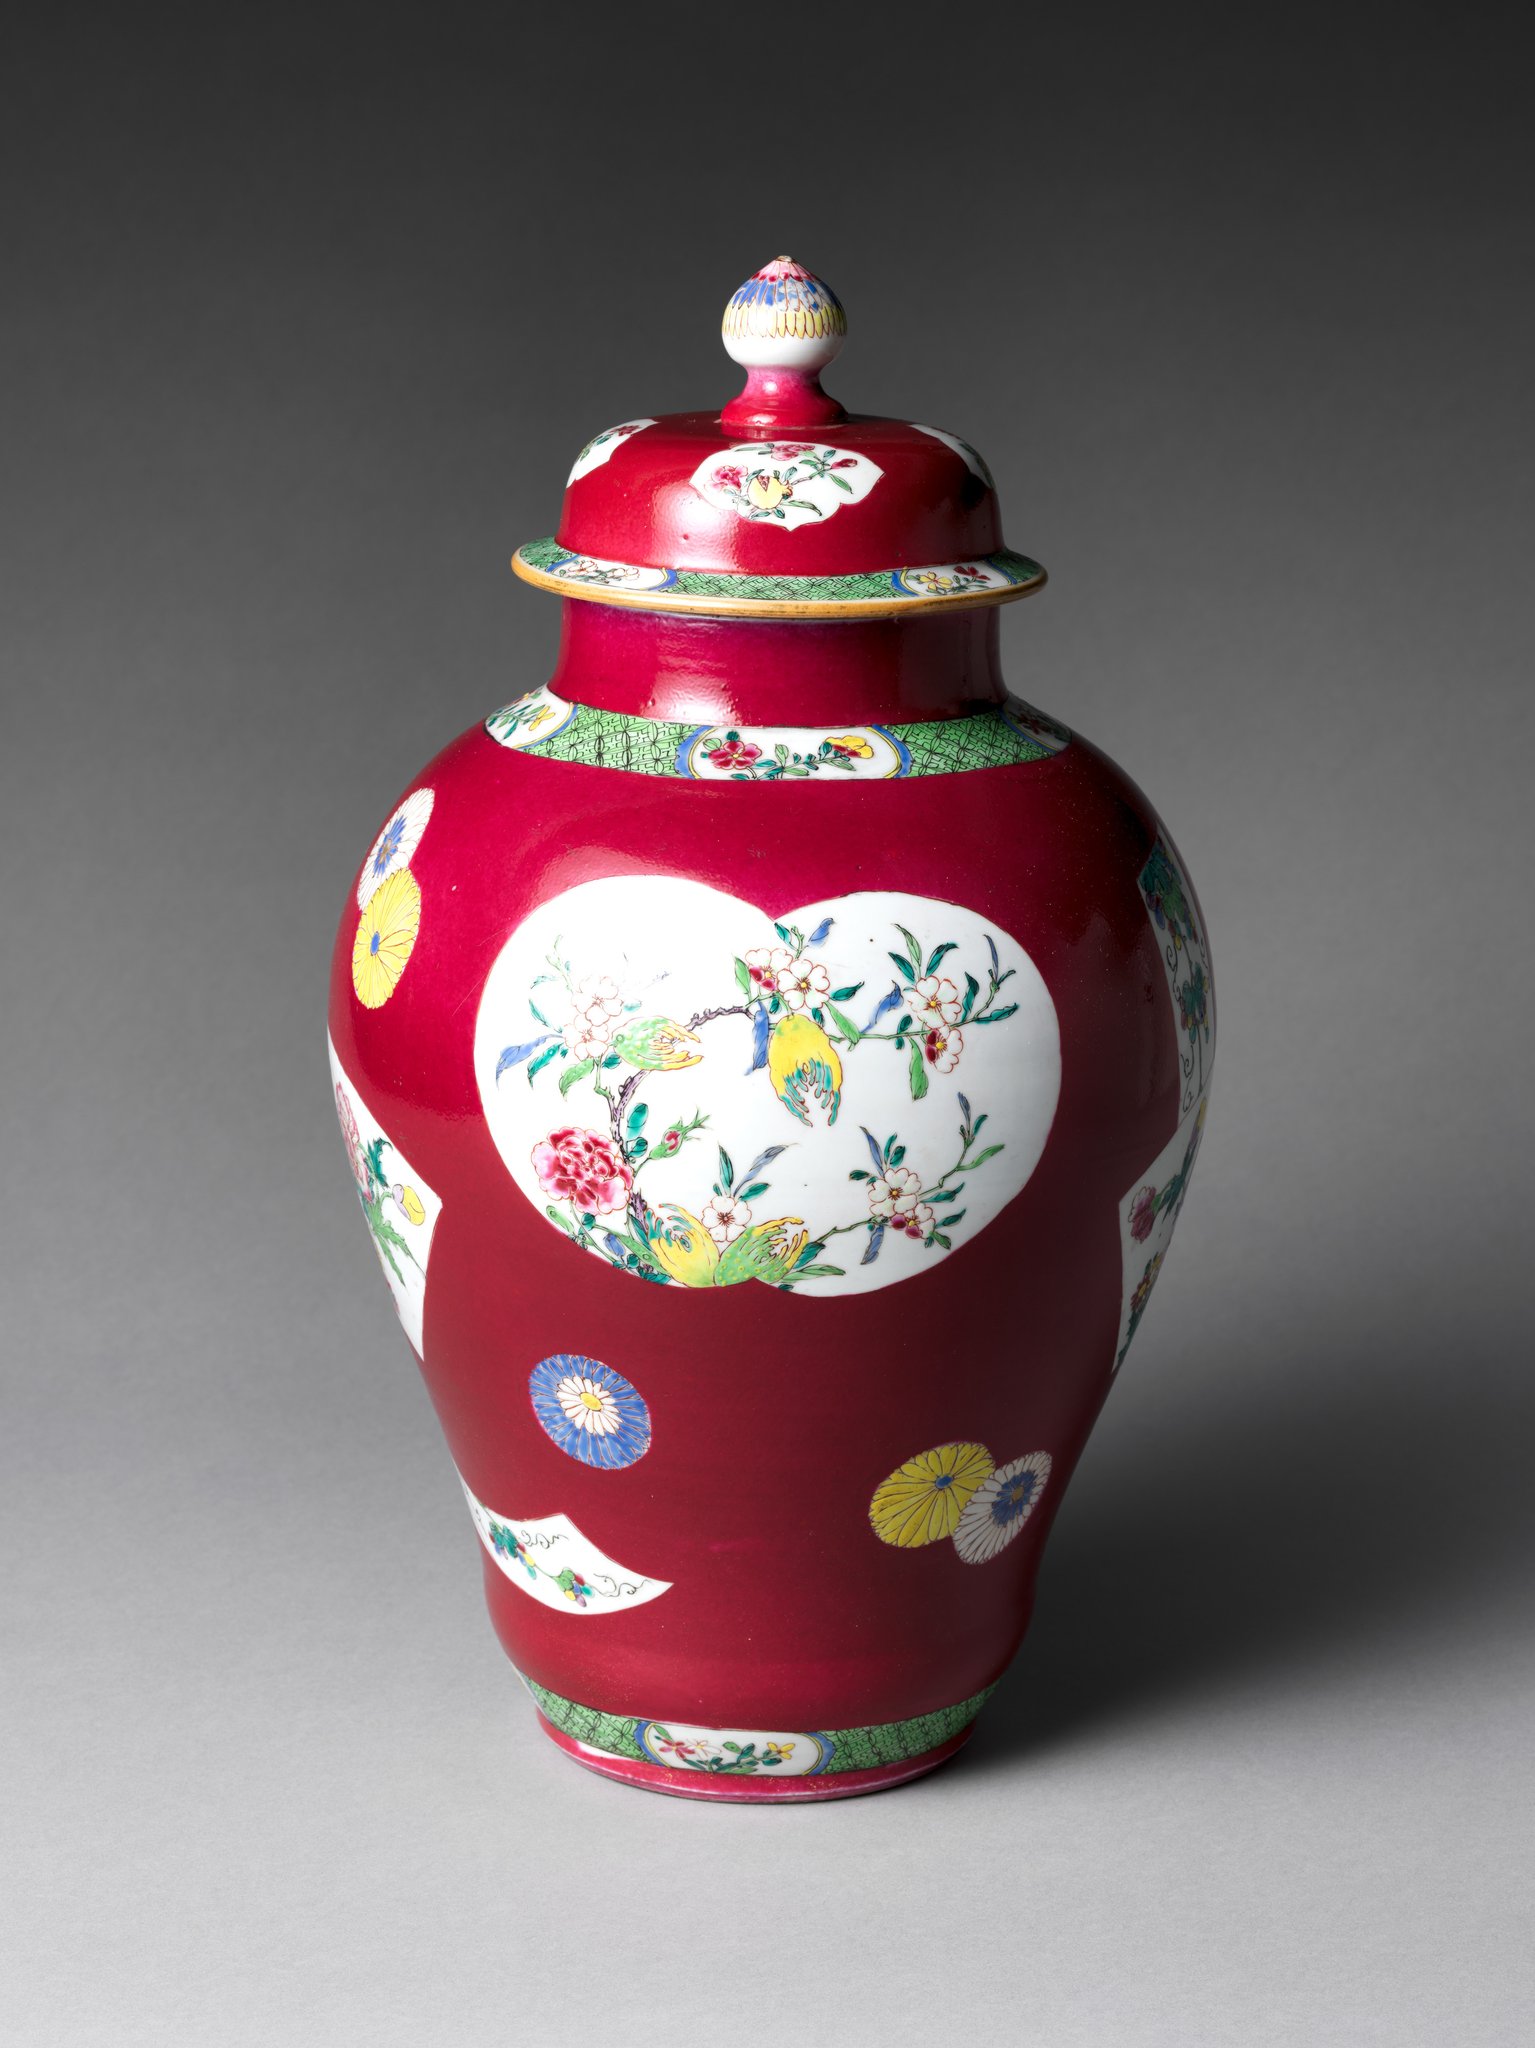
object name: jar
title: Jar with Flowers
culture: chinese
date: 1734-1766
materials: enamel, glaze, porcelain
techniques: painting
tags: flowers